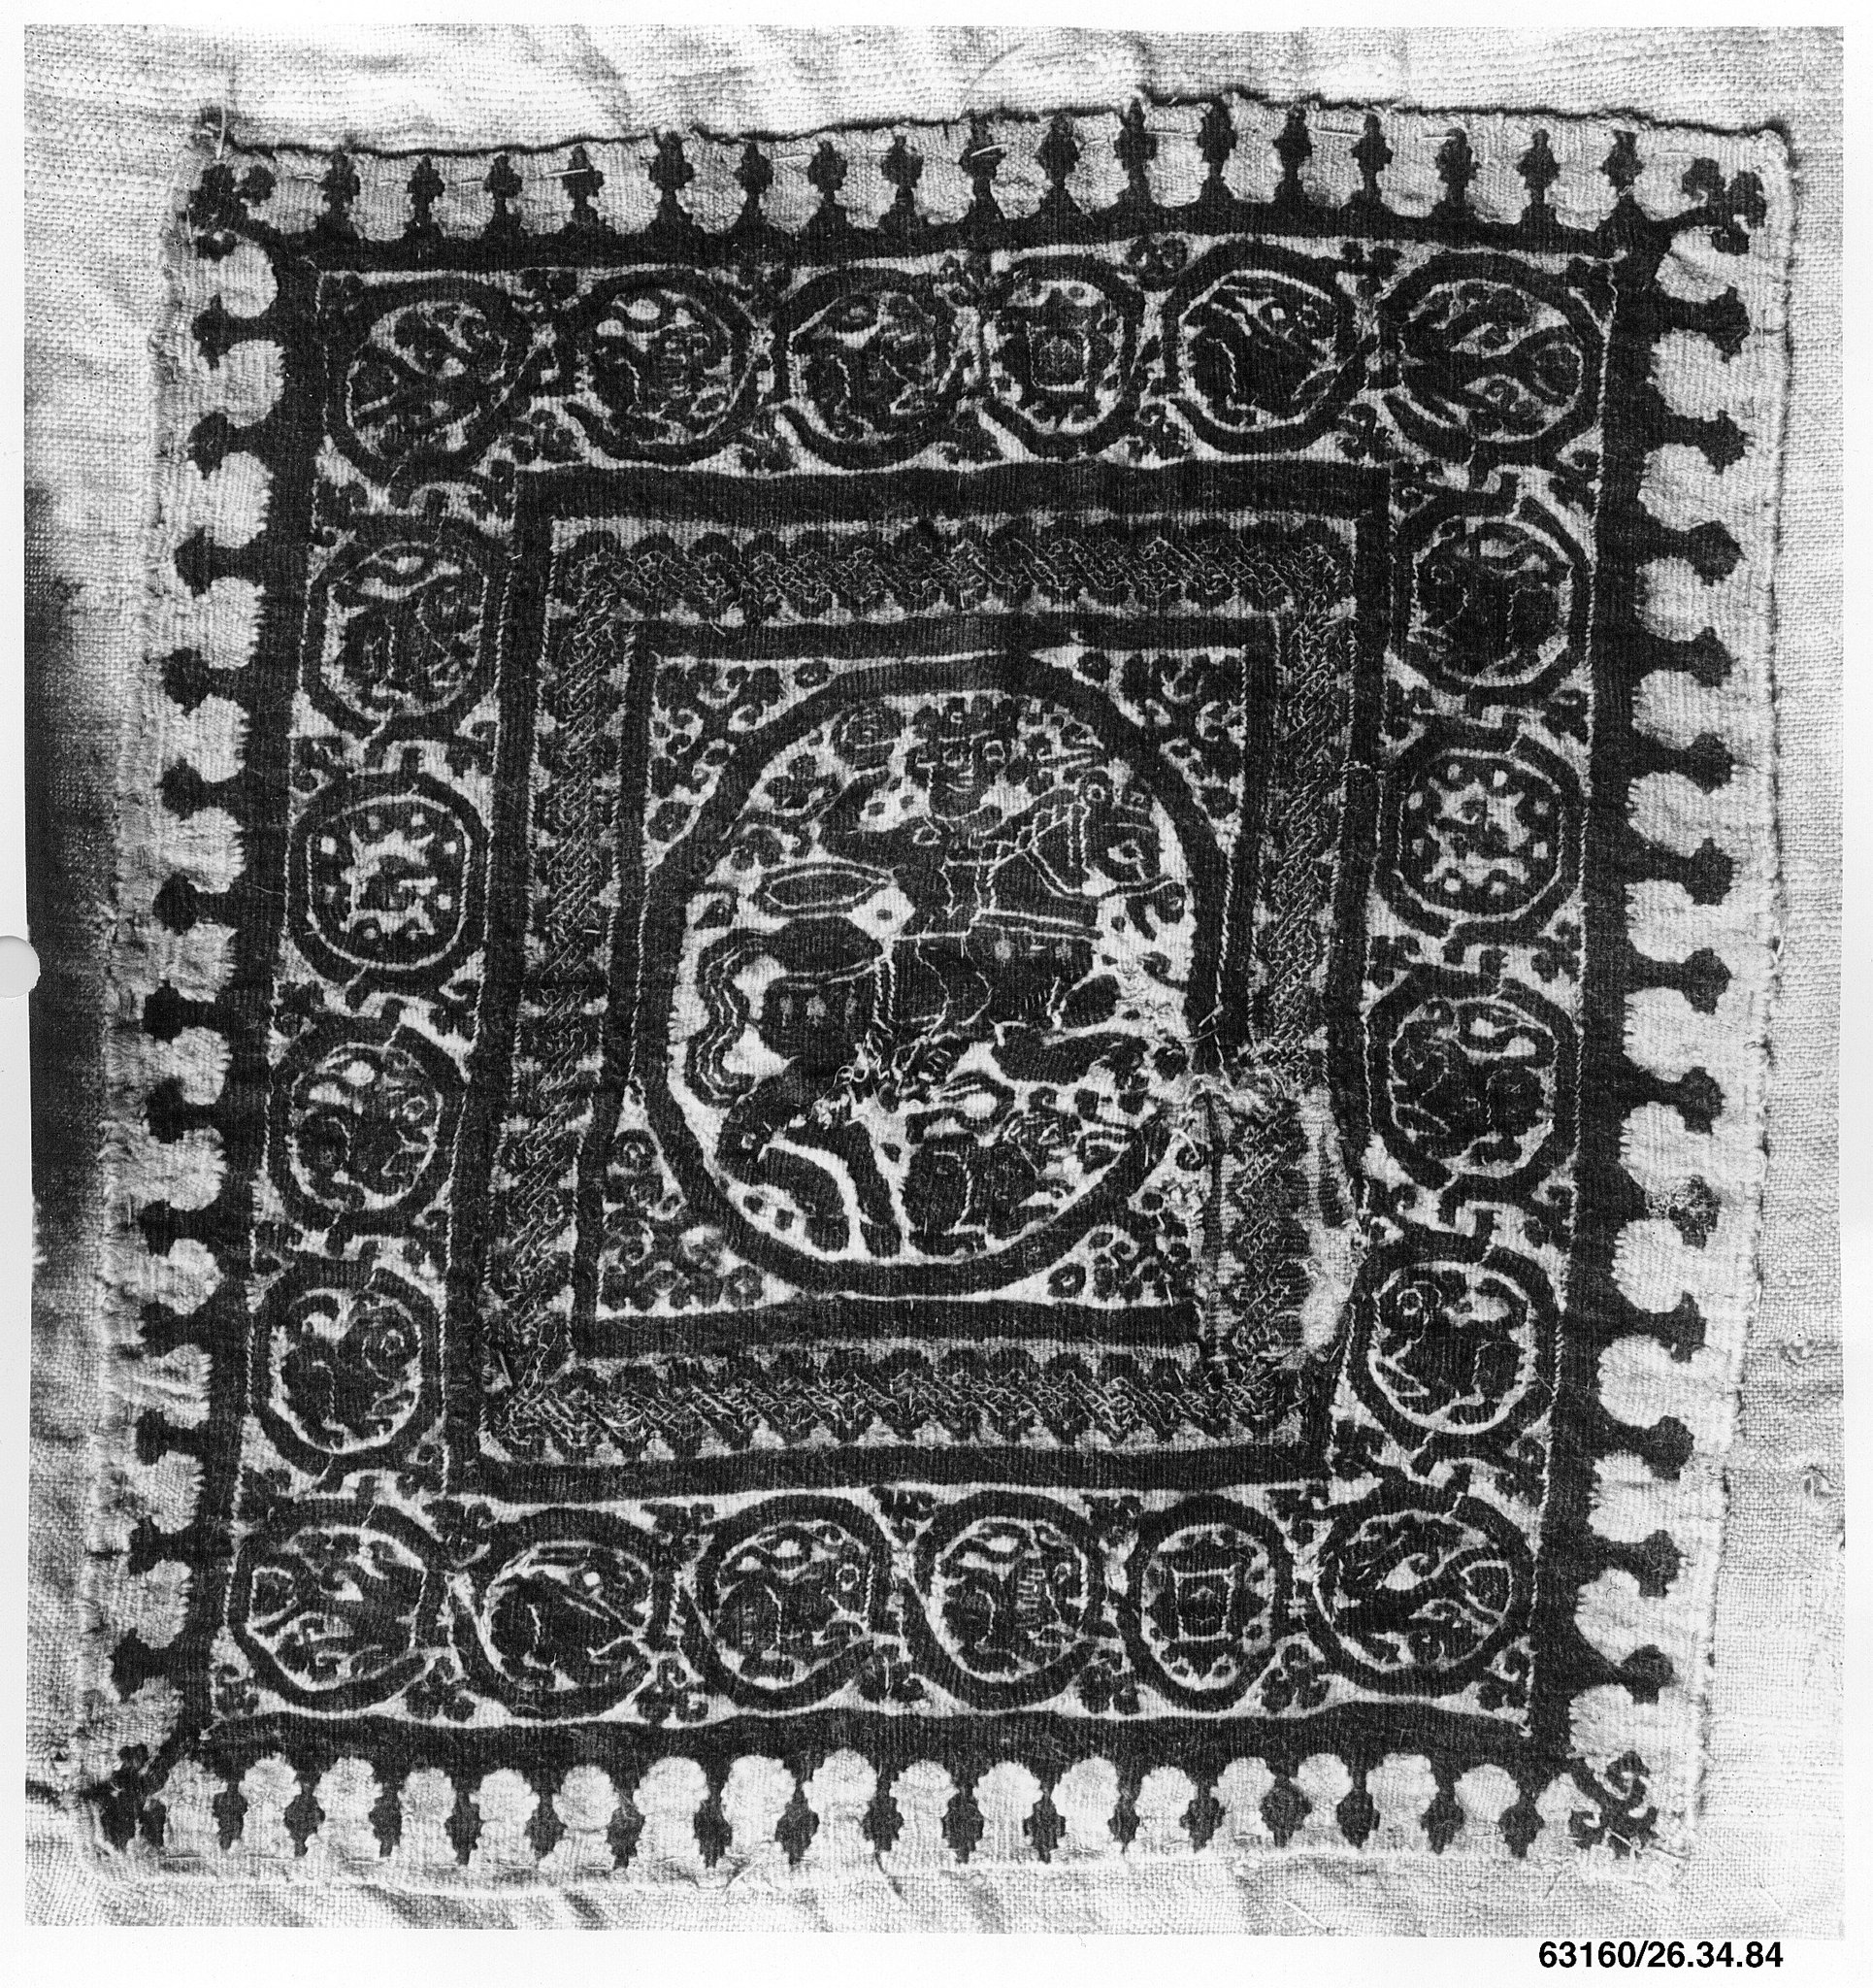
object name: panel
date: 301-400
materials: linen, wool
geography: egypt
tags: animals,horses